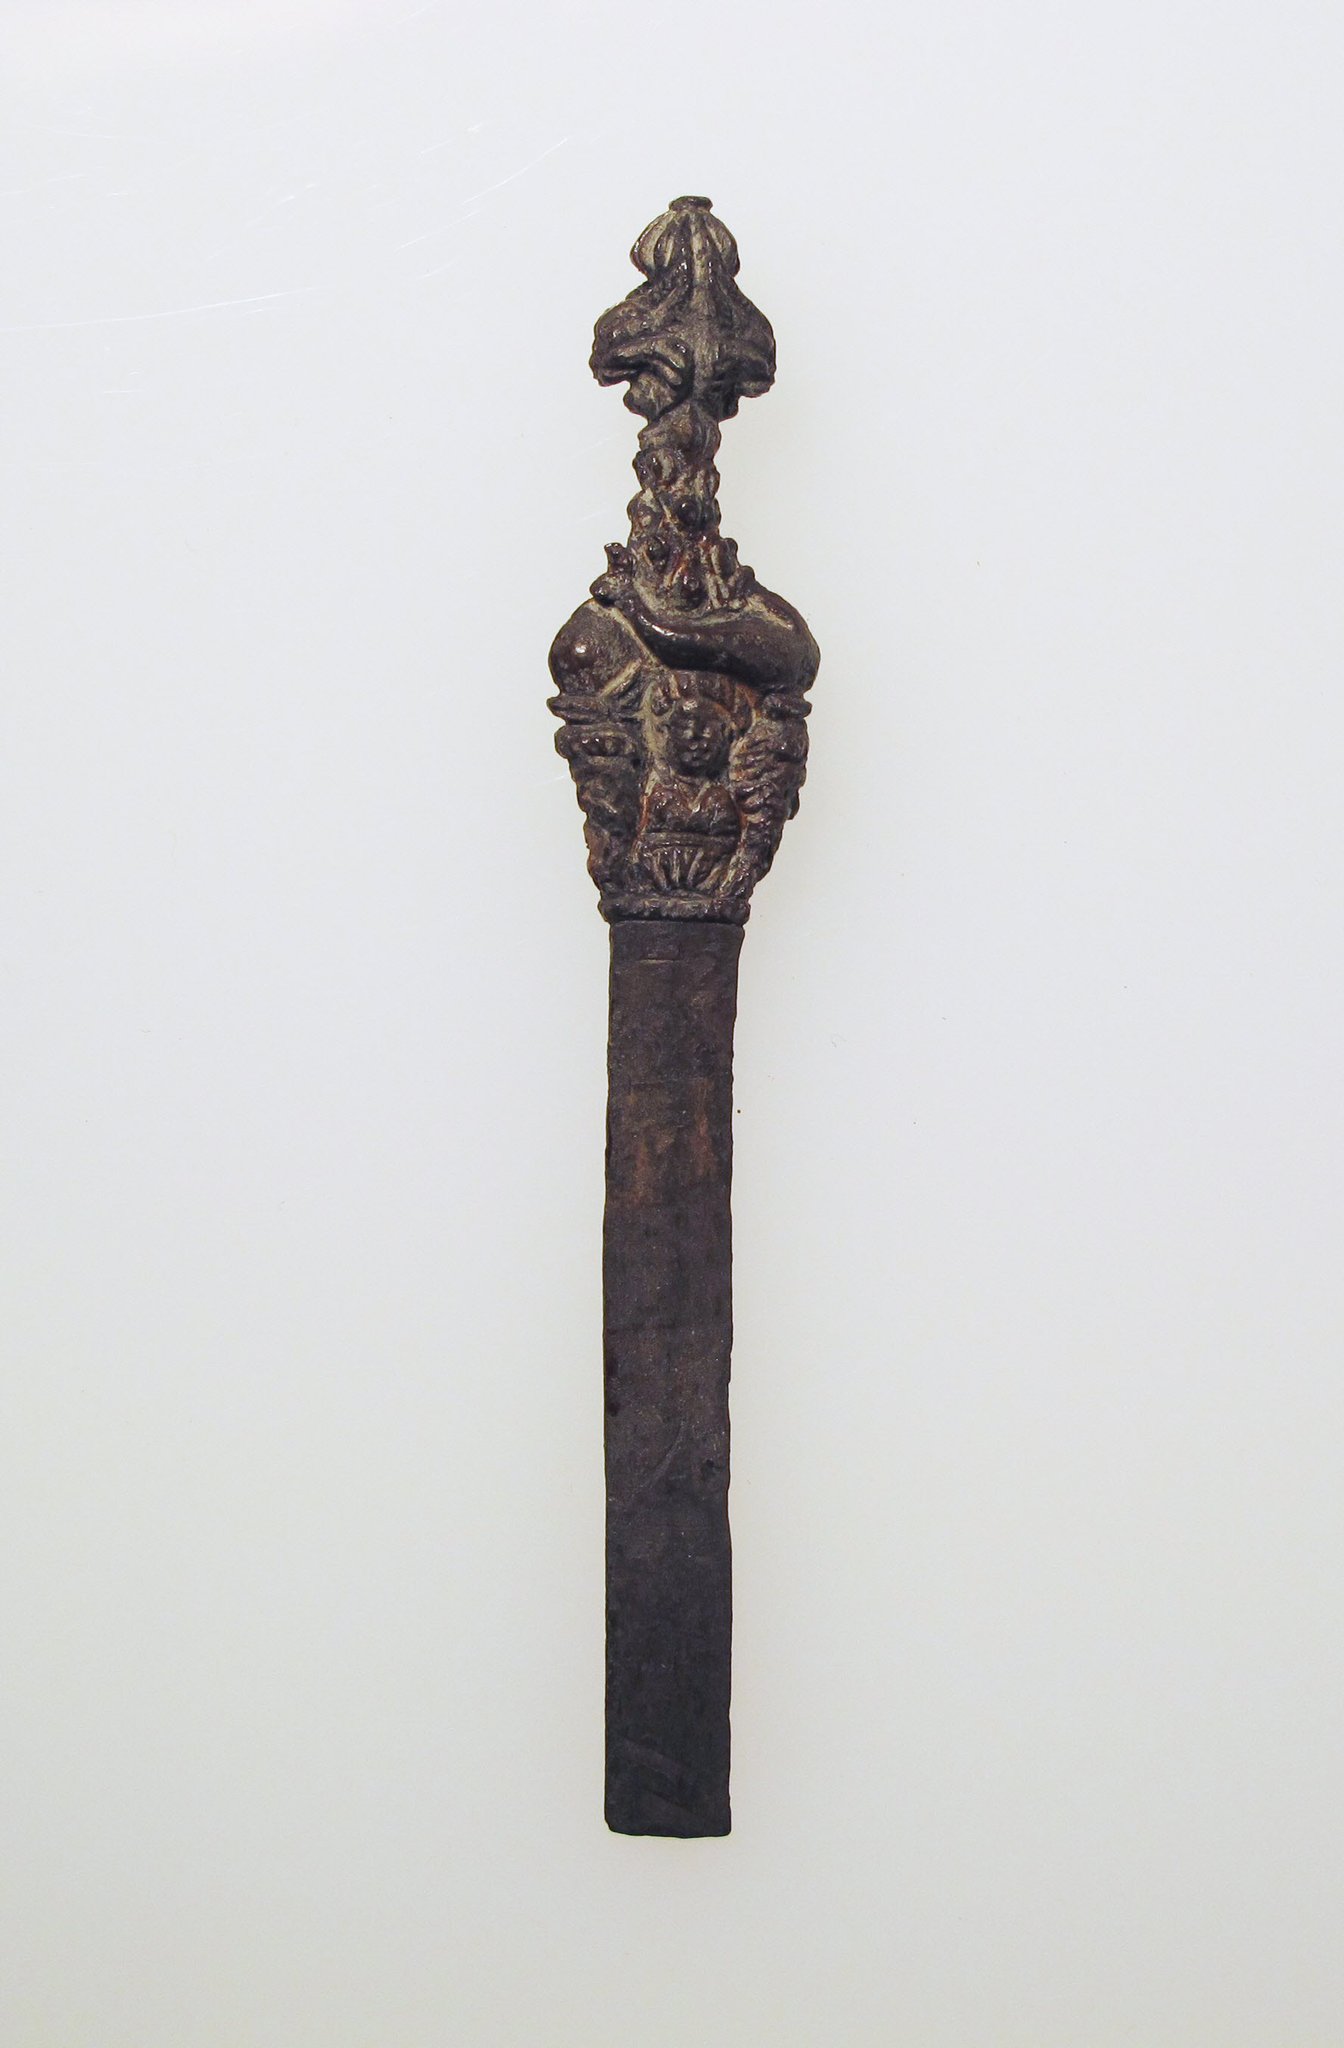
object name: hair pin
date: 7000 BCE-330 CE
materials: silver